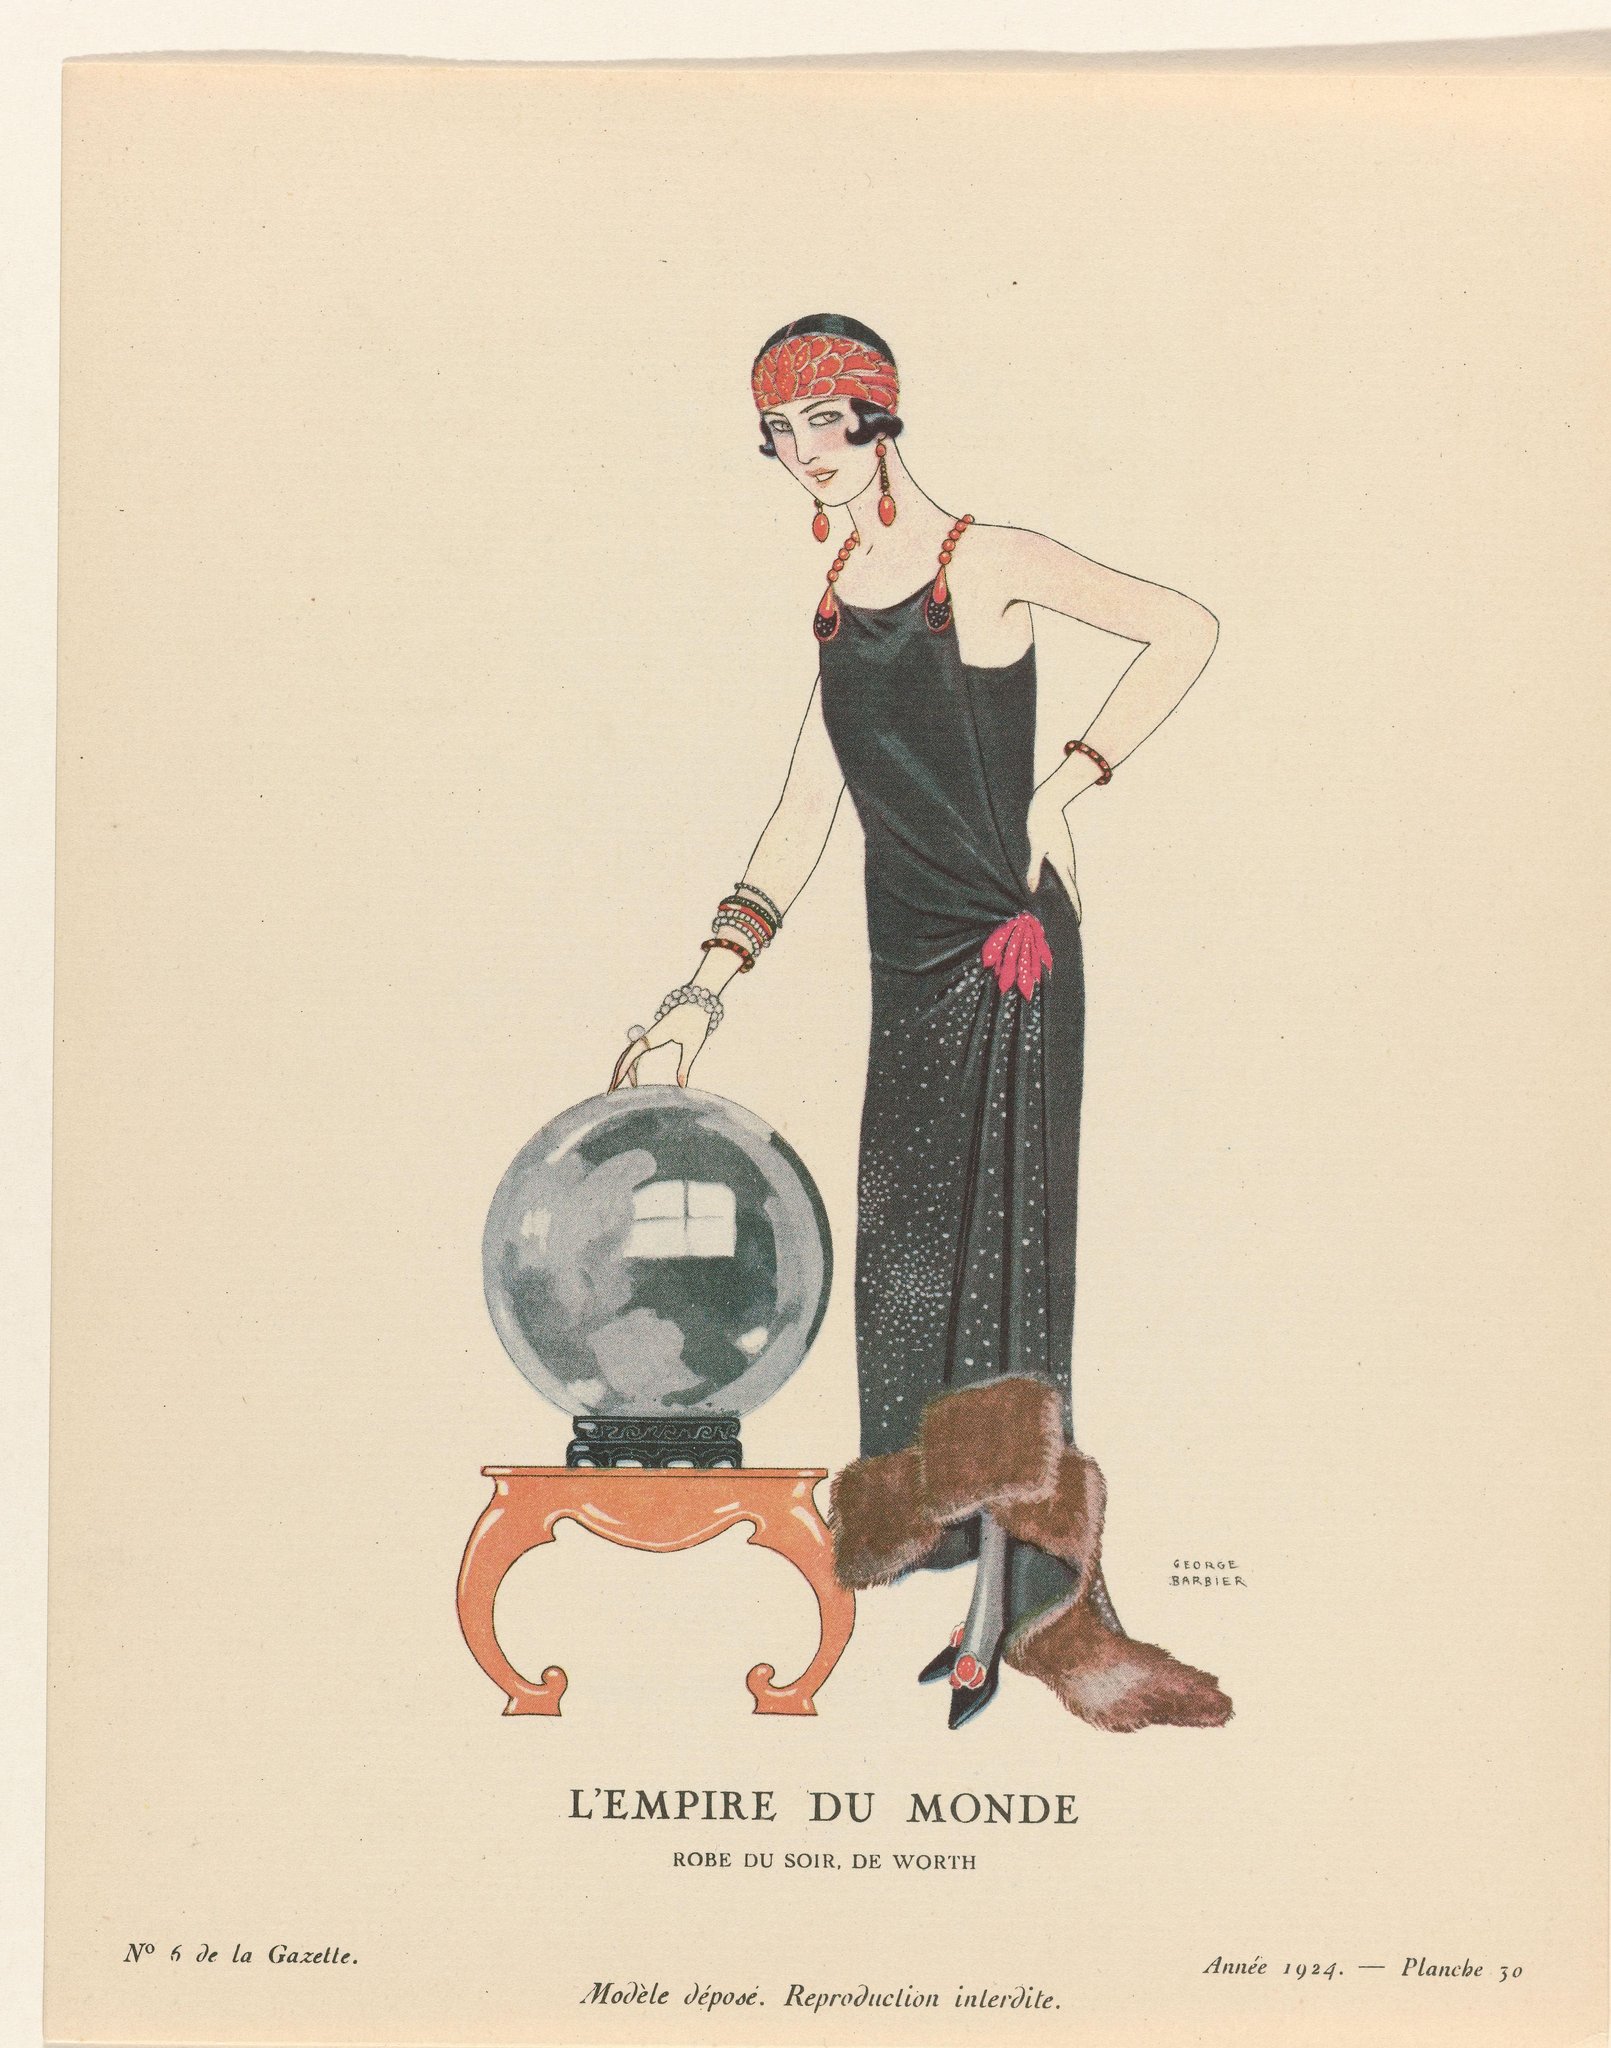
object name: fashion print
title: Gazette du Bon Ton. Art- Modes & Frivolités, 1924 - No. 6 : L'Empire du monde / Robe du soir, de Worth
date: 1924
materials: paper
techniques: printing, letterpress printing, photochemical processes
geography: paris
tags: ear-rings (+ women's clothes), dress, gown: evening dress (+ women's clothes), ring (+ women's clothes), head-gear (+ women's clothes), fashion plates, table, bracelet, wristlet (+ women's clothes)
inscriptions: caption: ‘Modèle déposé. Reproduction interdite.’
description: Staande vrouw bij een grote glazen bol, gekleed in een avondjapon met sleep, aan de zoom afgezet met bont, van Worth. Zij draagt een brede hoofdband. Planche 30 uit Gazette du Bon Ton 1924, No. 6.